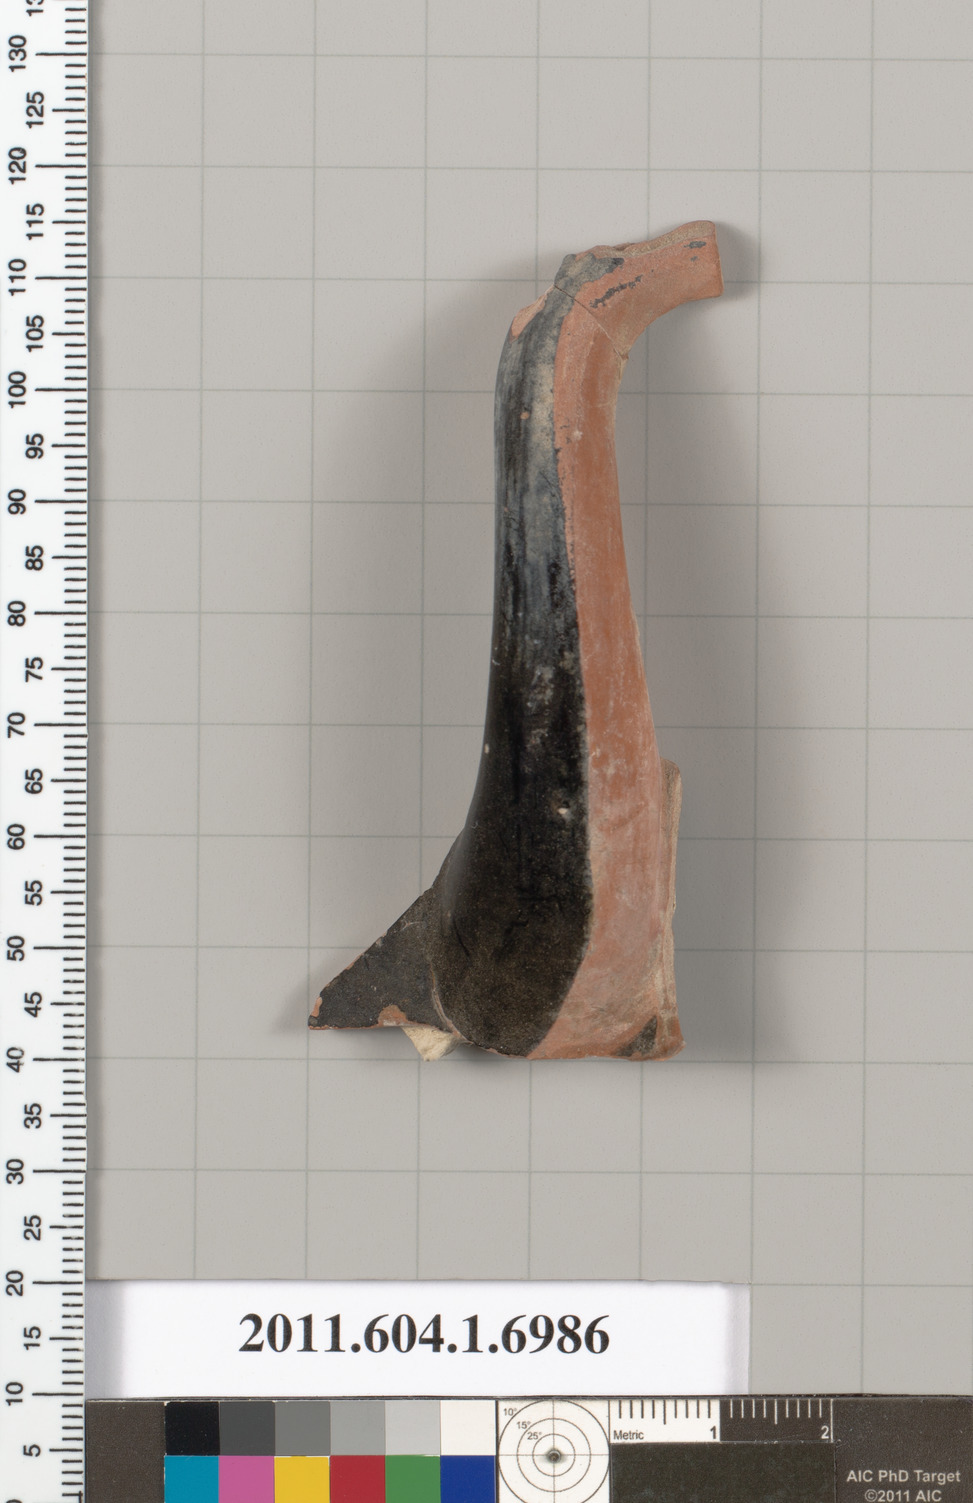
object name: kylix fragment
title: Terracotta fragment of a kylix (drinking cup)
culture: greek, attic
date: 490-470 BCE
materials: terracotta